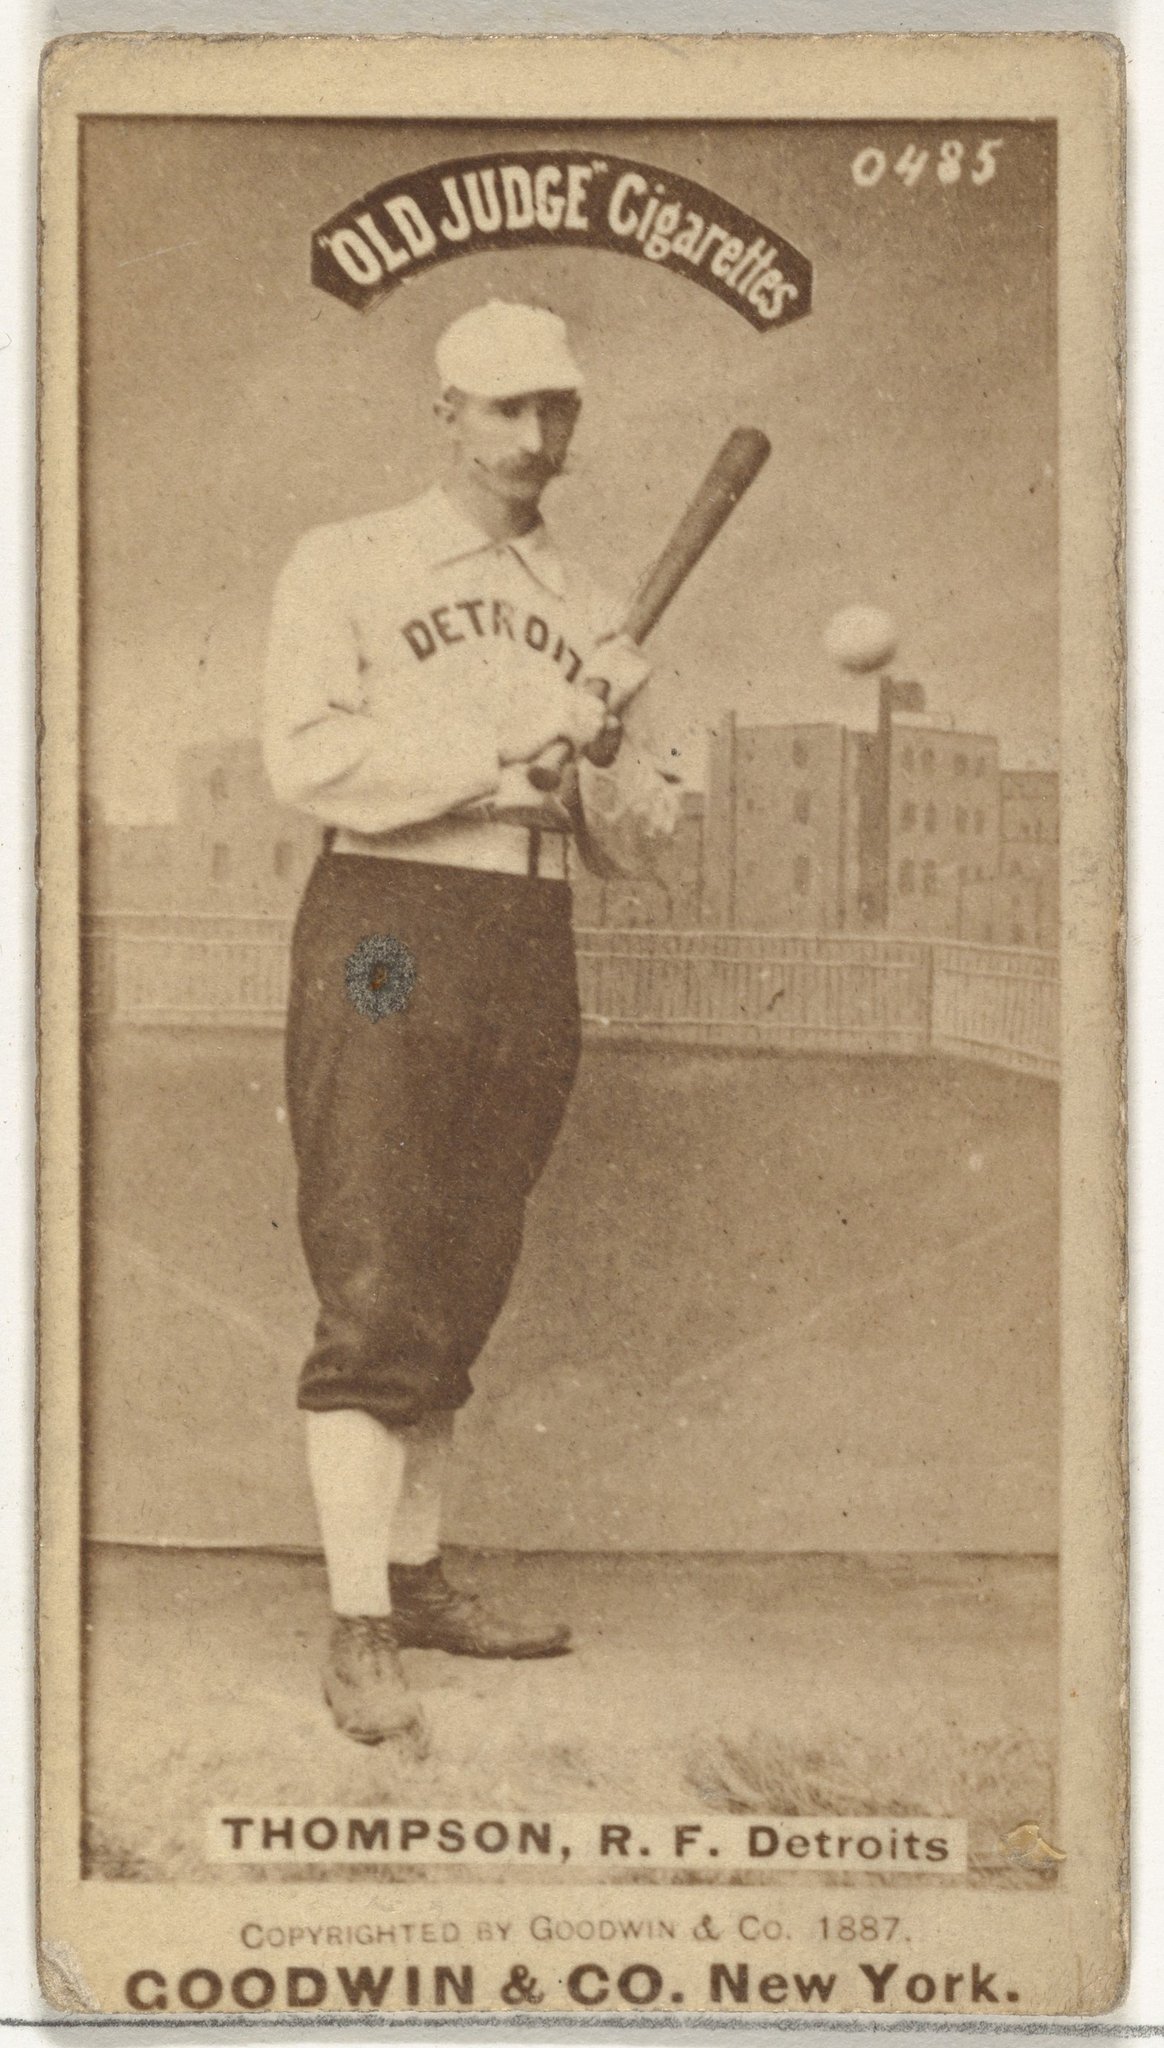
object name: baseball card, photograph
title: Samuel Luther "Sam" Thompson, Right Field, Detroit Wolverines, from the Old Judge series (N172) for Old Judge Cigarettes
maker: goodwin & company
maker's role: publisher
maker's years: 1850-1950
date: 1887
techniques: albumen silver print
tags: men,portraits,baseball,athletes